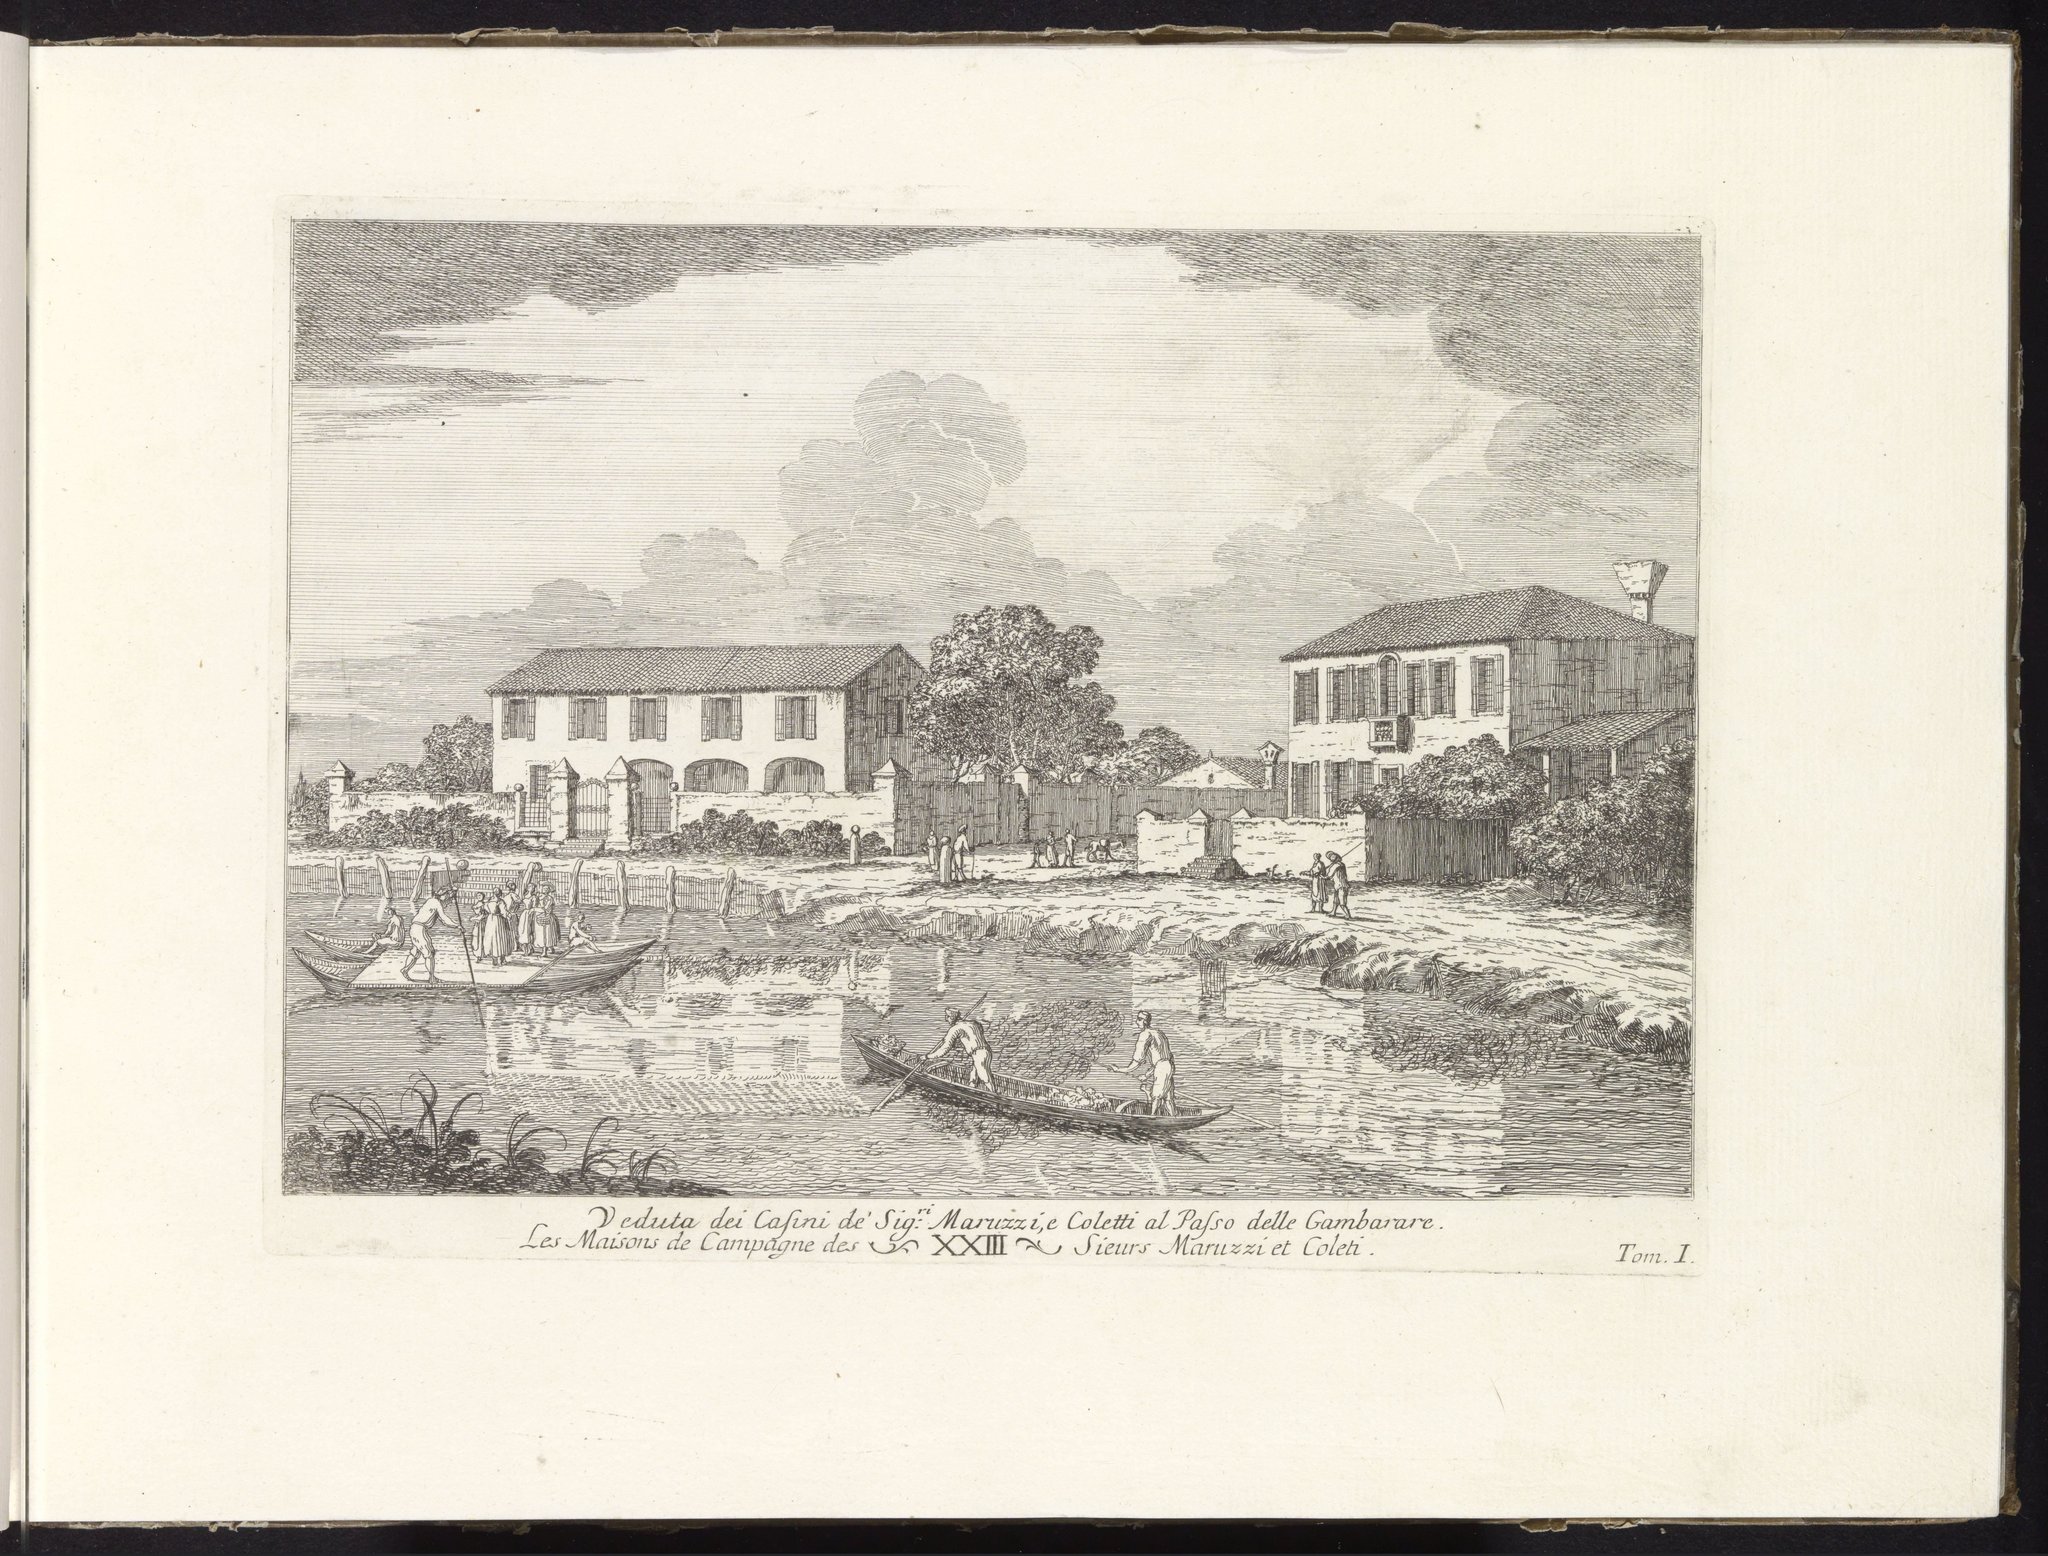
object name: print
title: Veduta dei Casini de' Sig.ri Maruzzi, e Coletti al Passo delle Gambarar (...)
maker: giovanni francesco costa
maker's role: draughtsman, painter, print maker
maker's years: -1773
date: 1750-1760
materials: paper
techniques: etching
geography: italy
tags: river, rural housing, e.g. country-house, villa, cottage, gondola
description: Gezicht op twee villa's aan de rivier de Brenta. Op het water varen verschillende gondels. Genummerd midden onder: XXIII en rechtsonder: Tom: I. Deze prent maakt deel uit van een album.